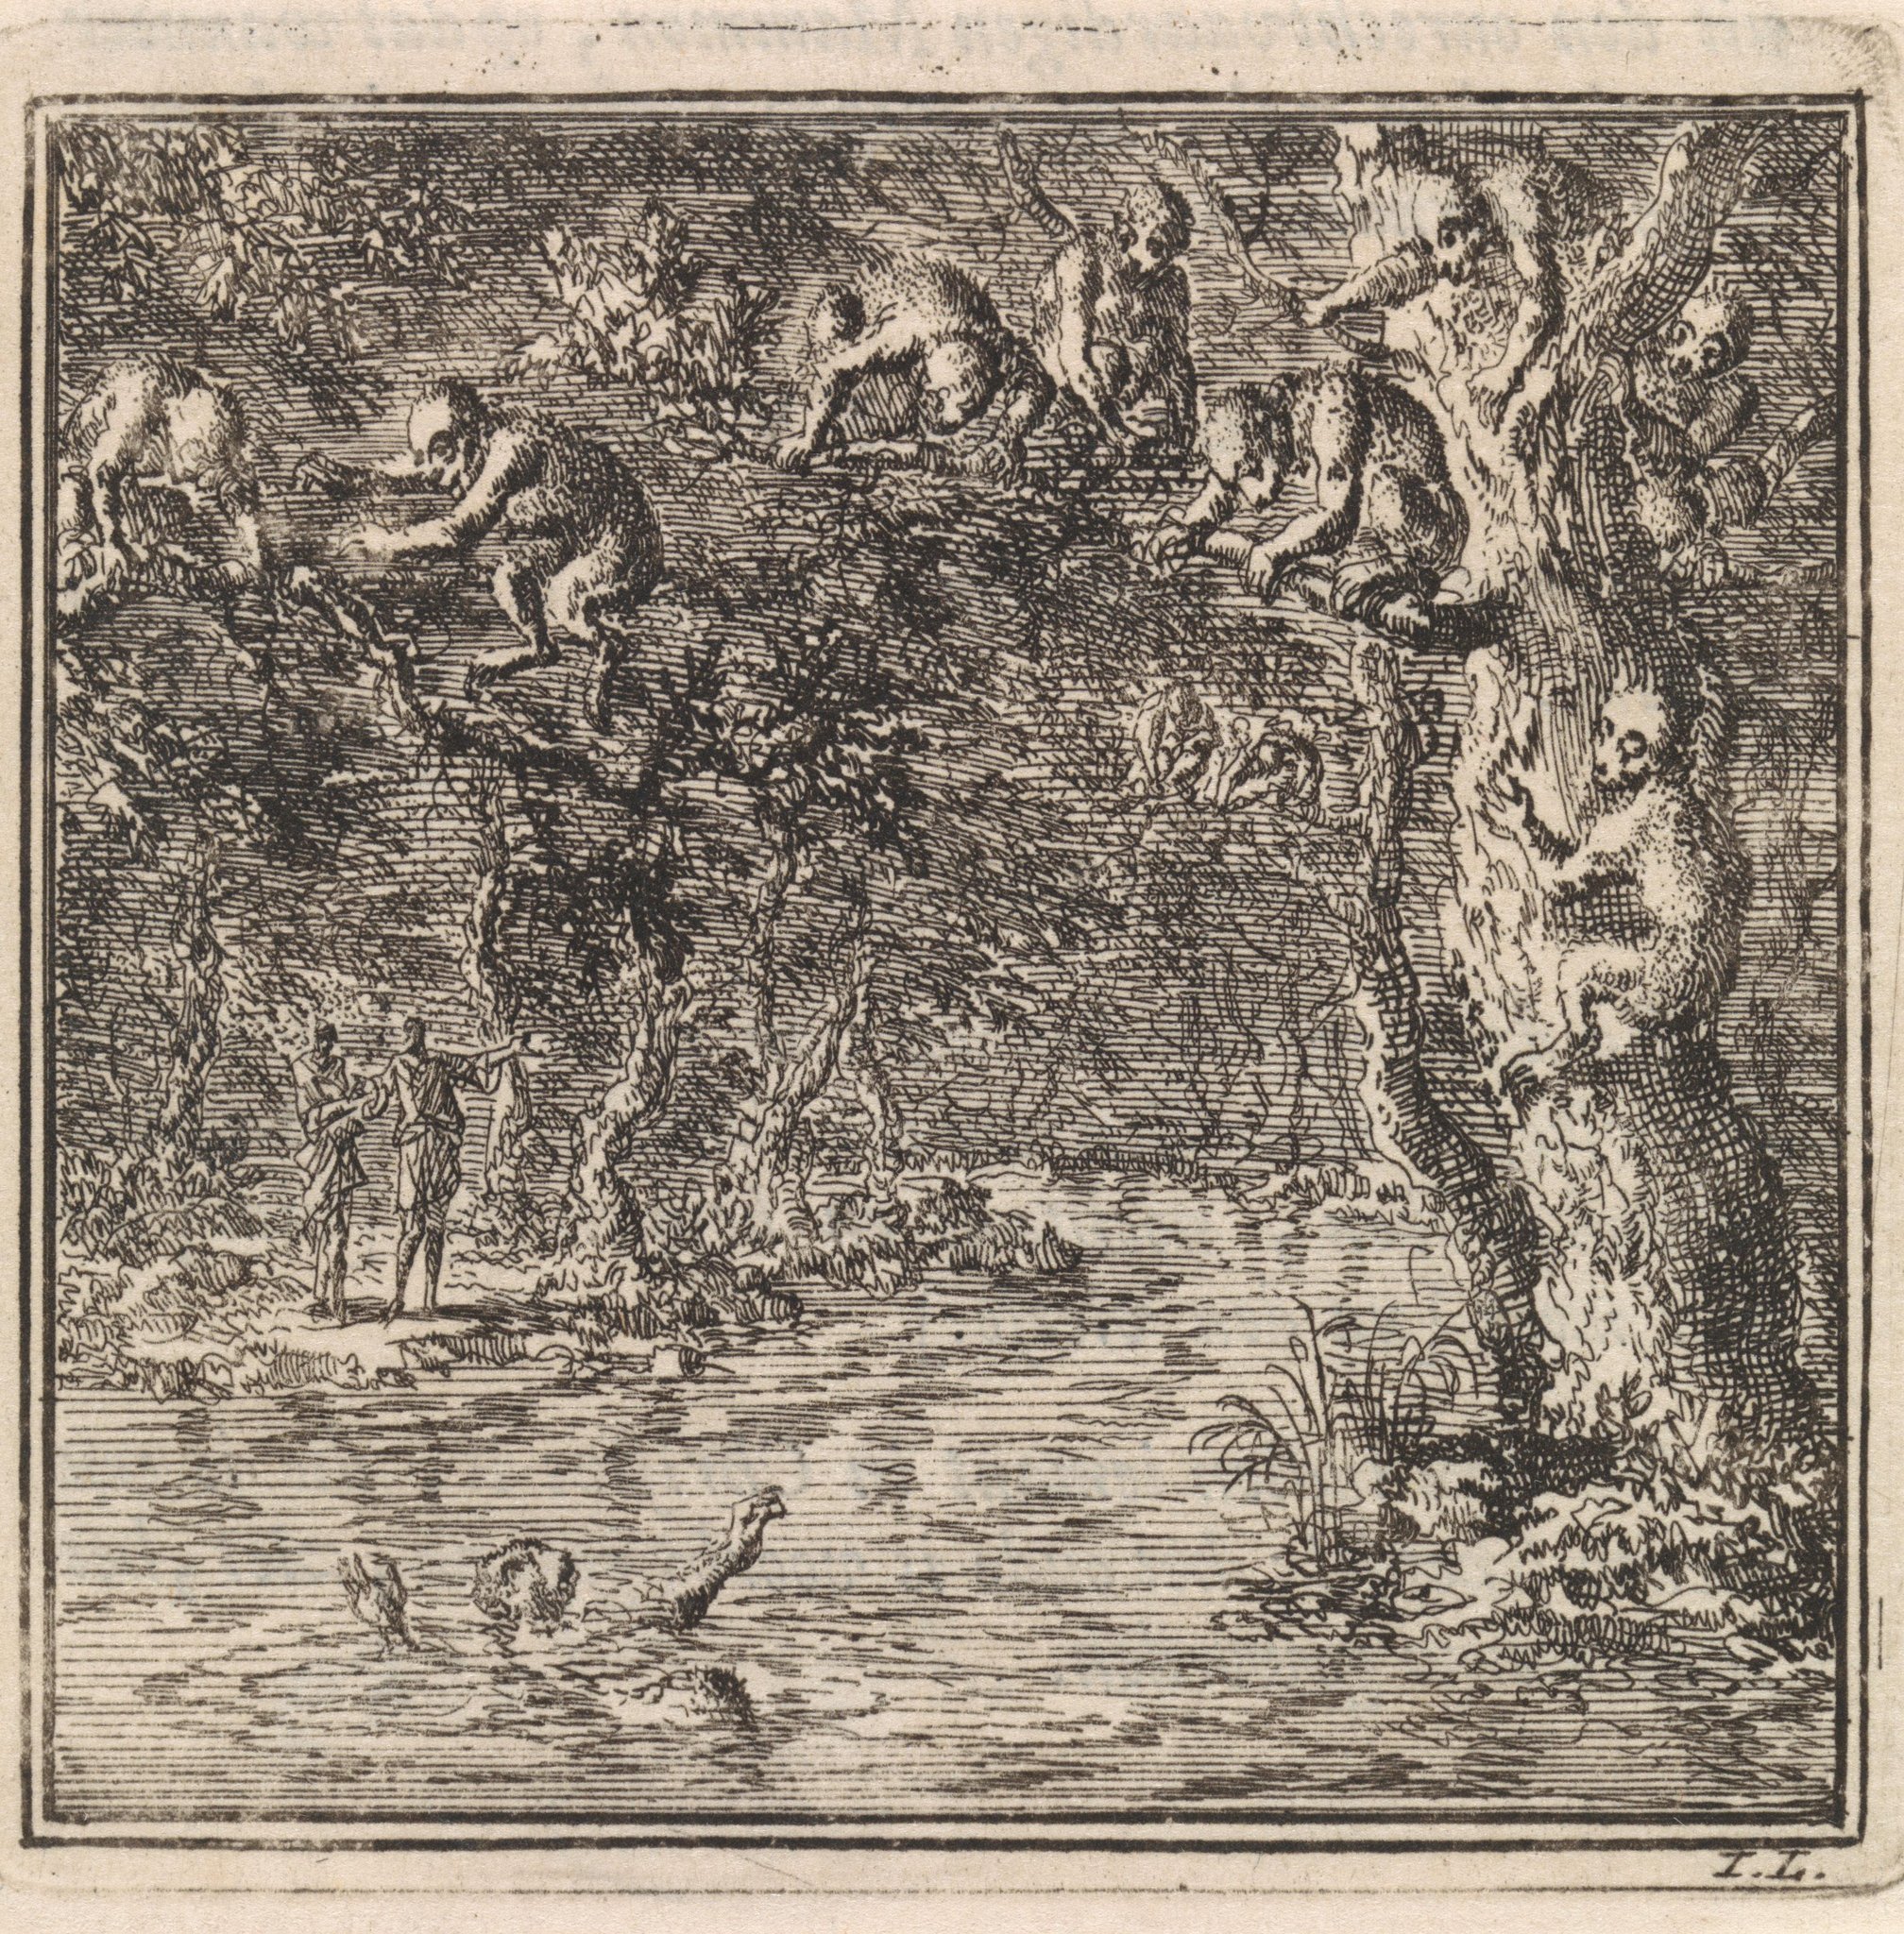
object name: book illustration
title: De Aapen-vreugd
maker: jan luyken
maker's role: draughtsman, print maker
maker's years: 1649-1712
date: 1711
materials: paper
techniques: etching, letterpress printing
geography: amsterdam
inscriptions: collector's mark: Lugt 2228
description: Illustratie voor: Luyken, Jan. De Bykorf des Gemoeds. Amsterdam: Pieter Arentsz. II (wed.) en Cornelis van der Sys, 1711, p. 162.